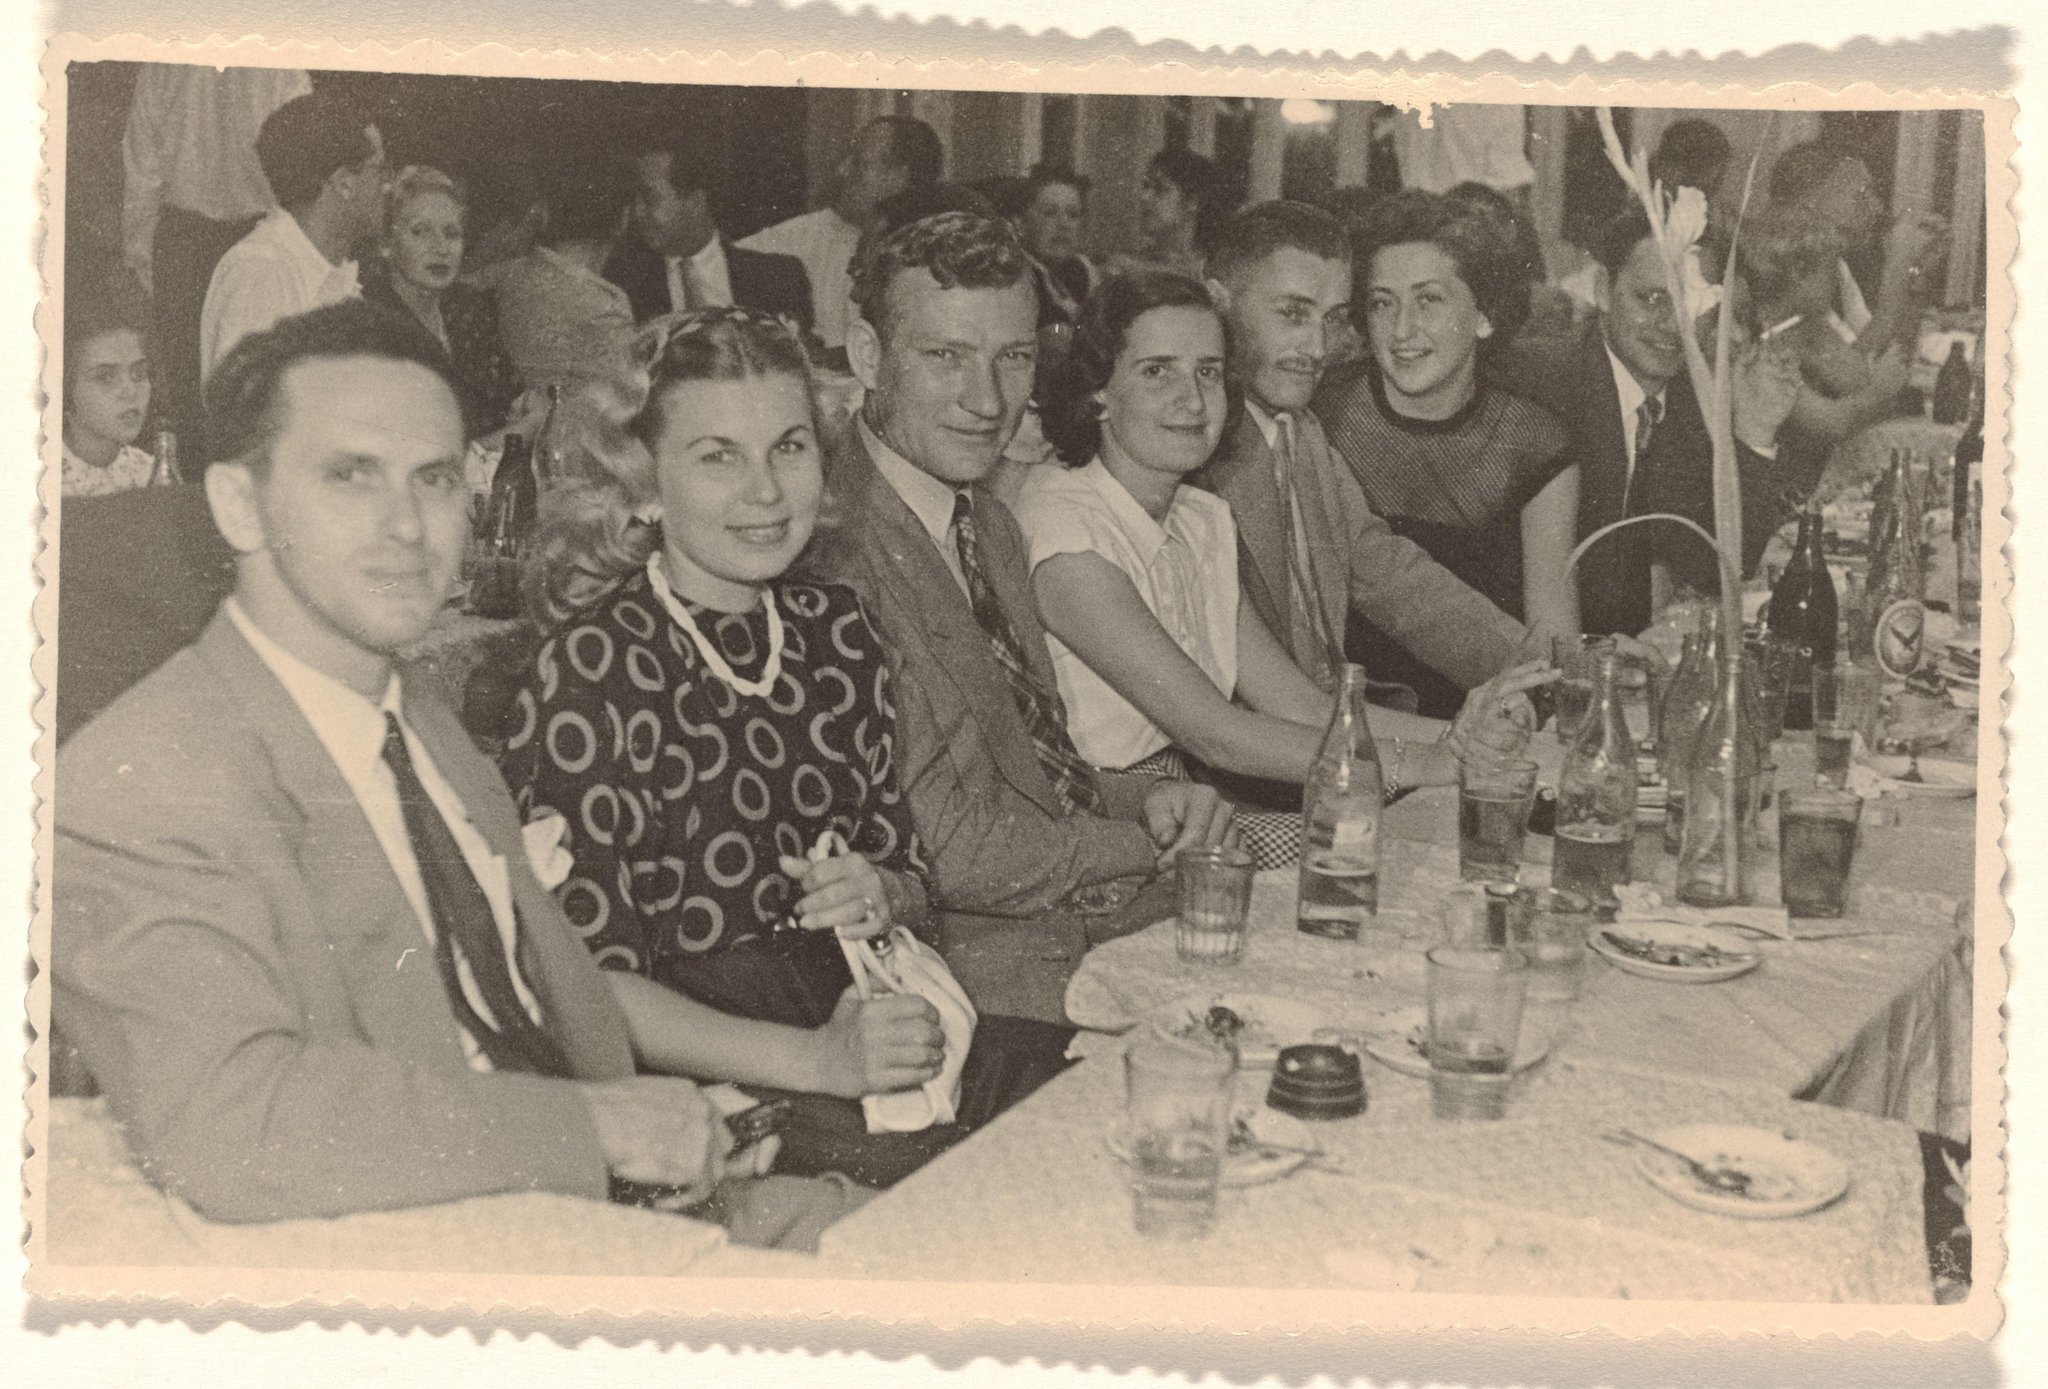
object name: photograph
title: Isabel Wachenheimer gezeten aan een tafel met flessen en glazen op tafel tijdens een feestelijke aangelegenheid met collega's van de KLM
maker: Anonymous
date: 1951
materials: photographic support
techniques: gelatin silver print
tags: leiden, isabel wachenheimer-elon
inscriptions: inscription: ‘Party 2. mit Flugplatzleute 1951’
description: Isabel Wachenheimer (vierde van links) gezeten aan een tafel met flessen en glazen op tafel tijdens een feestelijke aangelegenheid met collega's van de KLM.